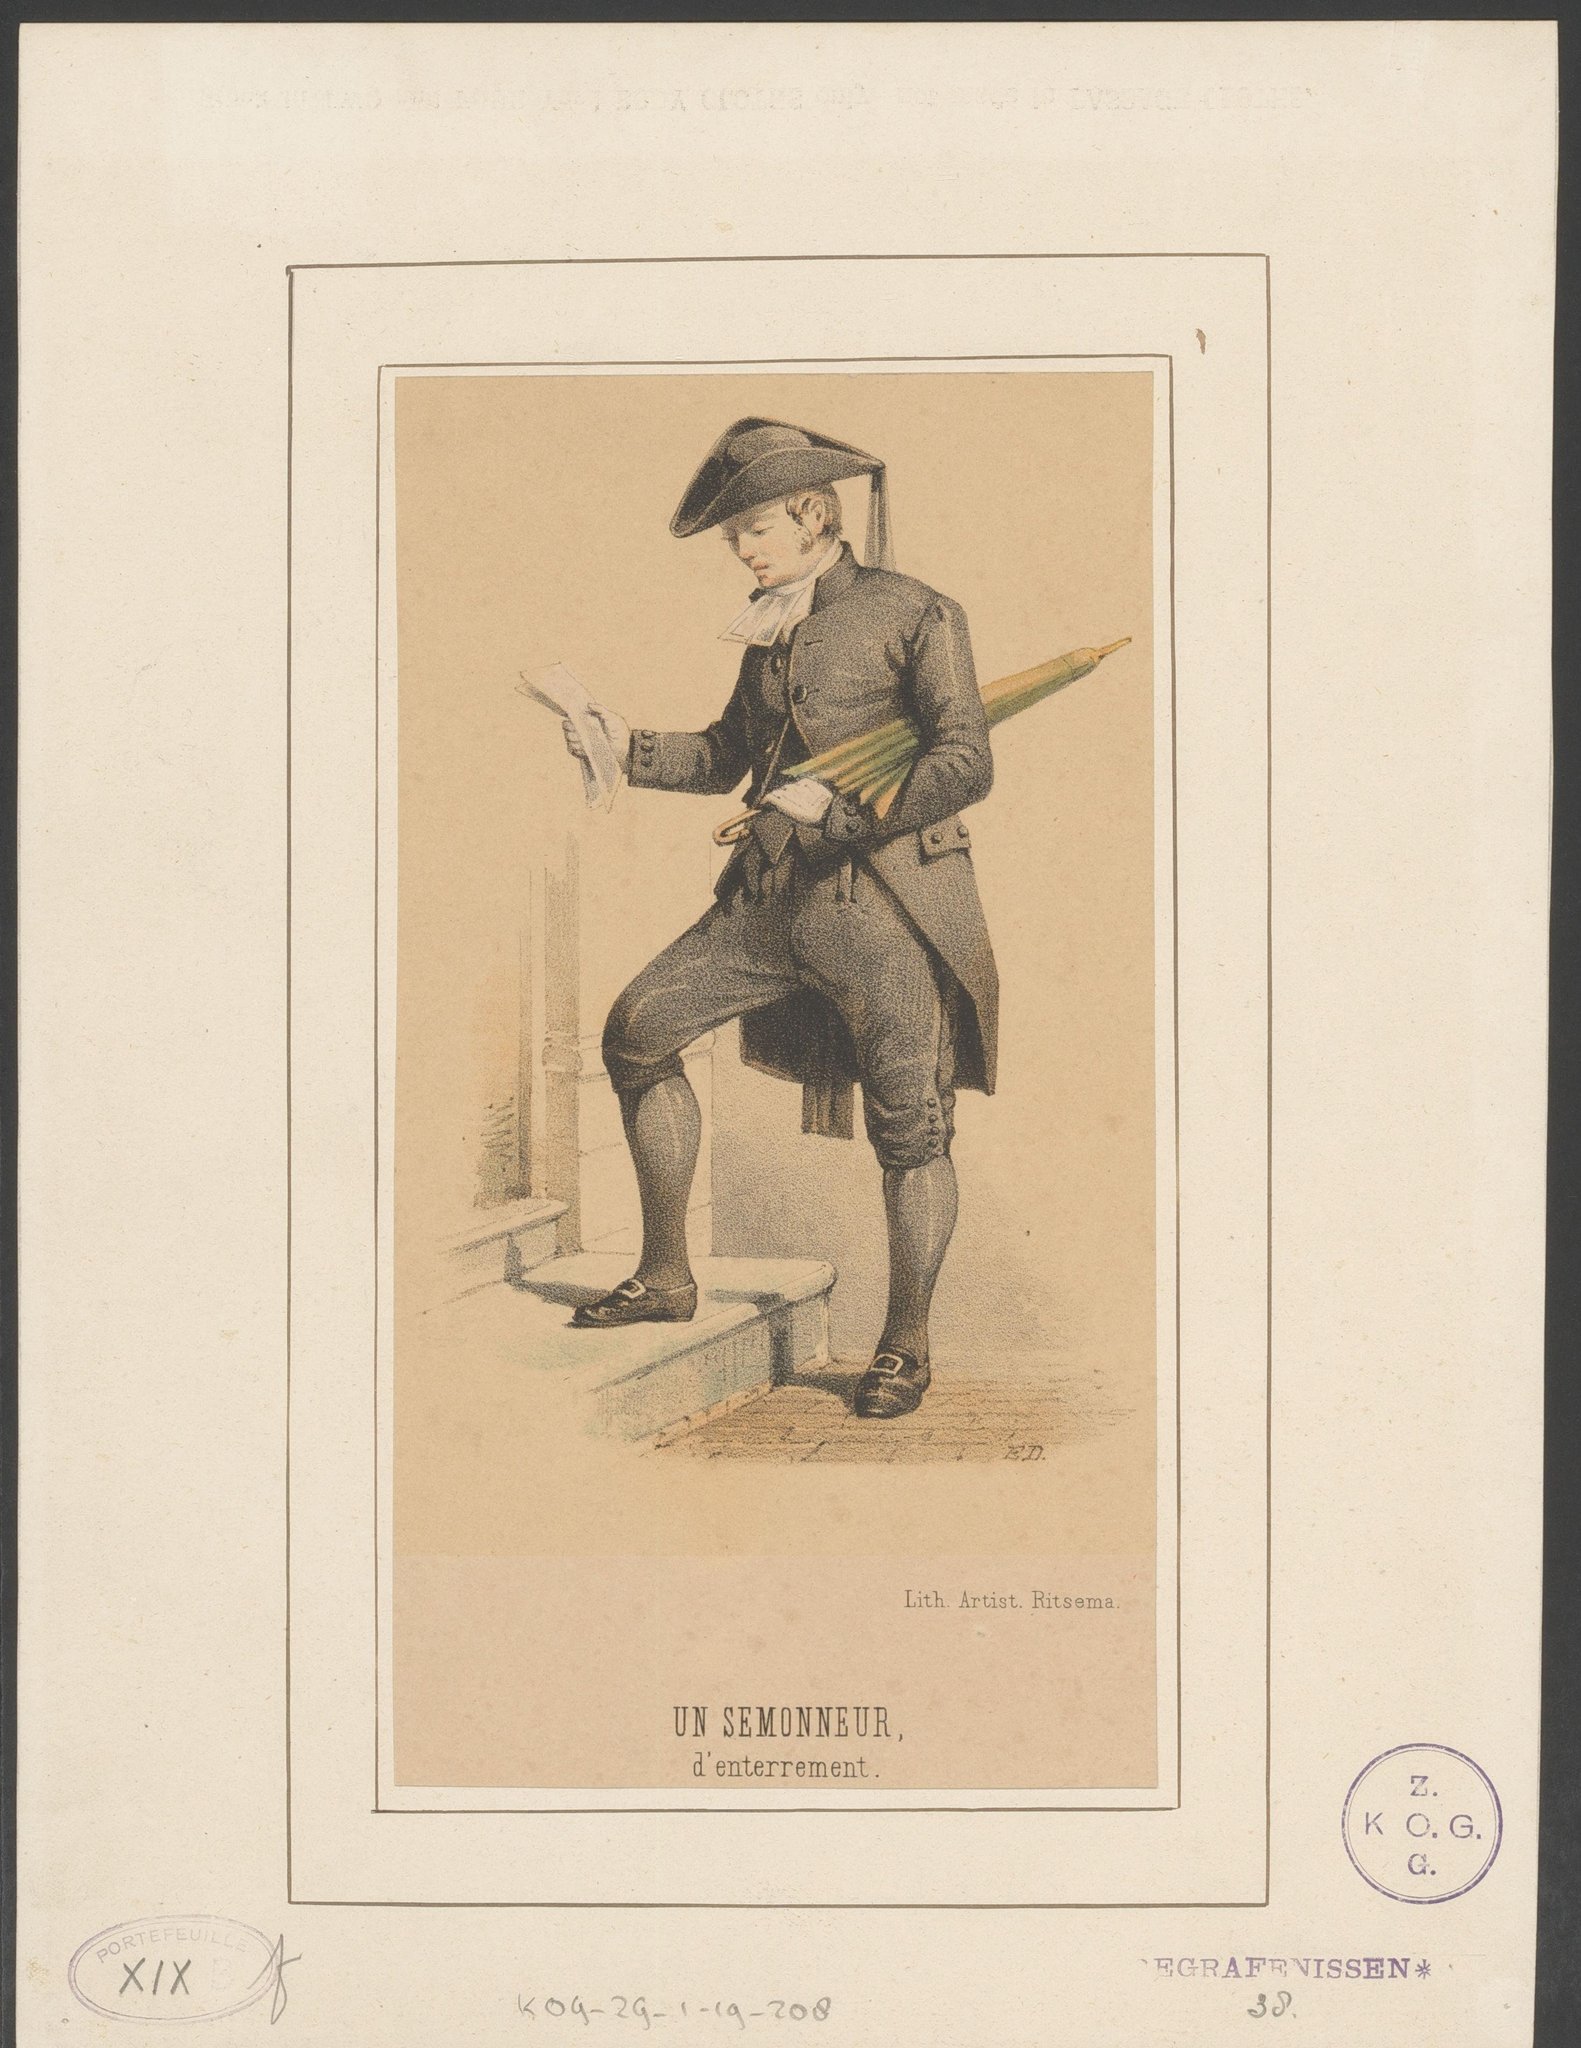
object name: print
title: Un semonneur d'enterrement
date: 1850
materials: paper, watercolor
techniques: hand coloring, lithograph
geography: netherlands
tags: oral announcement (of death), undertaker's man, clothes, costume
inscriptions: collector's mark, collector's mark: Lugt 1641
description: Een aanspreker leest het bericht voor over het overlijden van iemand. Staande bij een deur, hij draagt een hoed met afhangend rouwlint aan de achterzijde. Onderwerpsrubrieken binnen de Atlas Zeden en Gewoonten: Des Menschen Begin, Midden en Einde. Begrafenissen, aansprekers, doodgravers, enz.